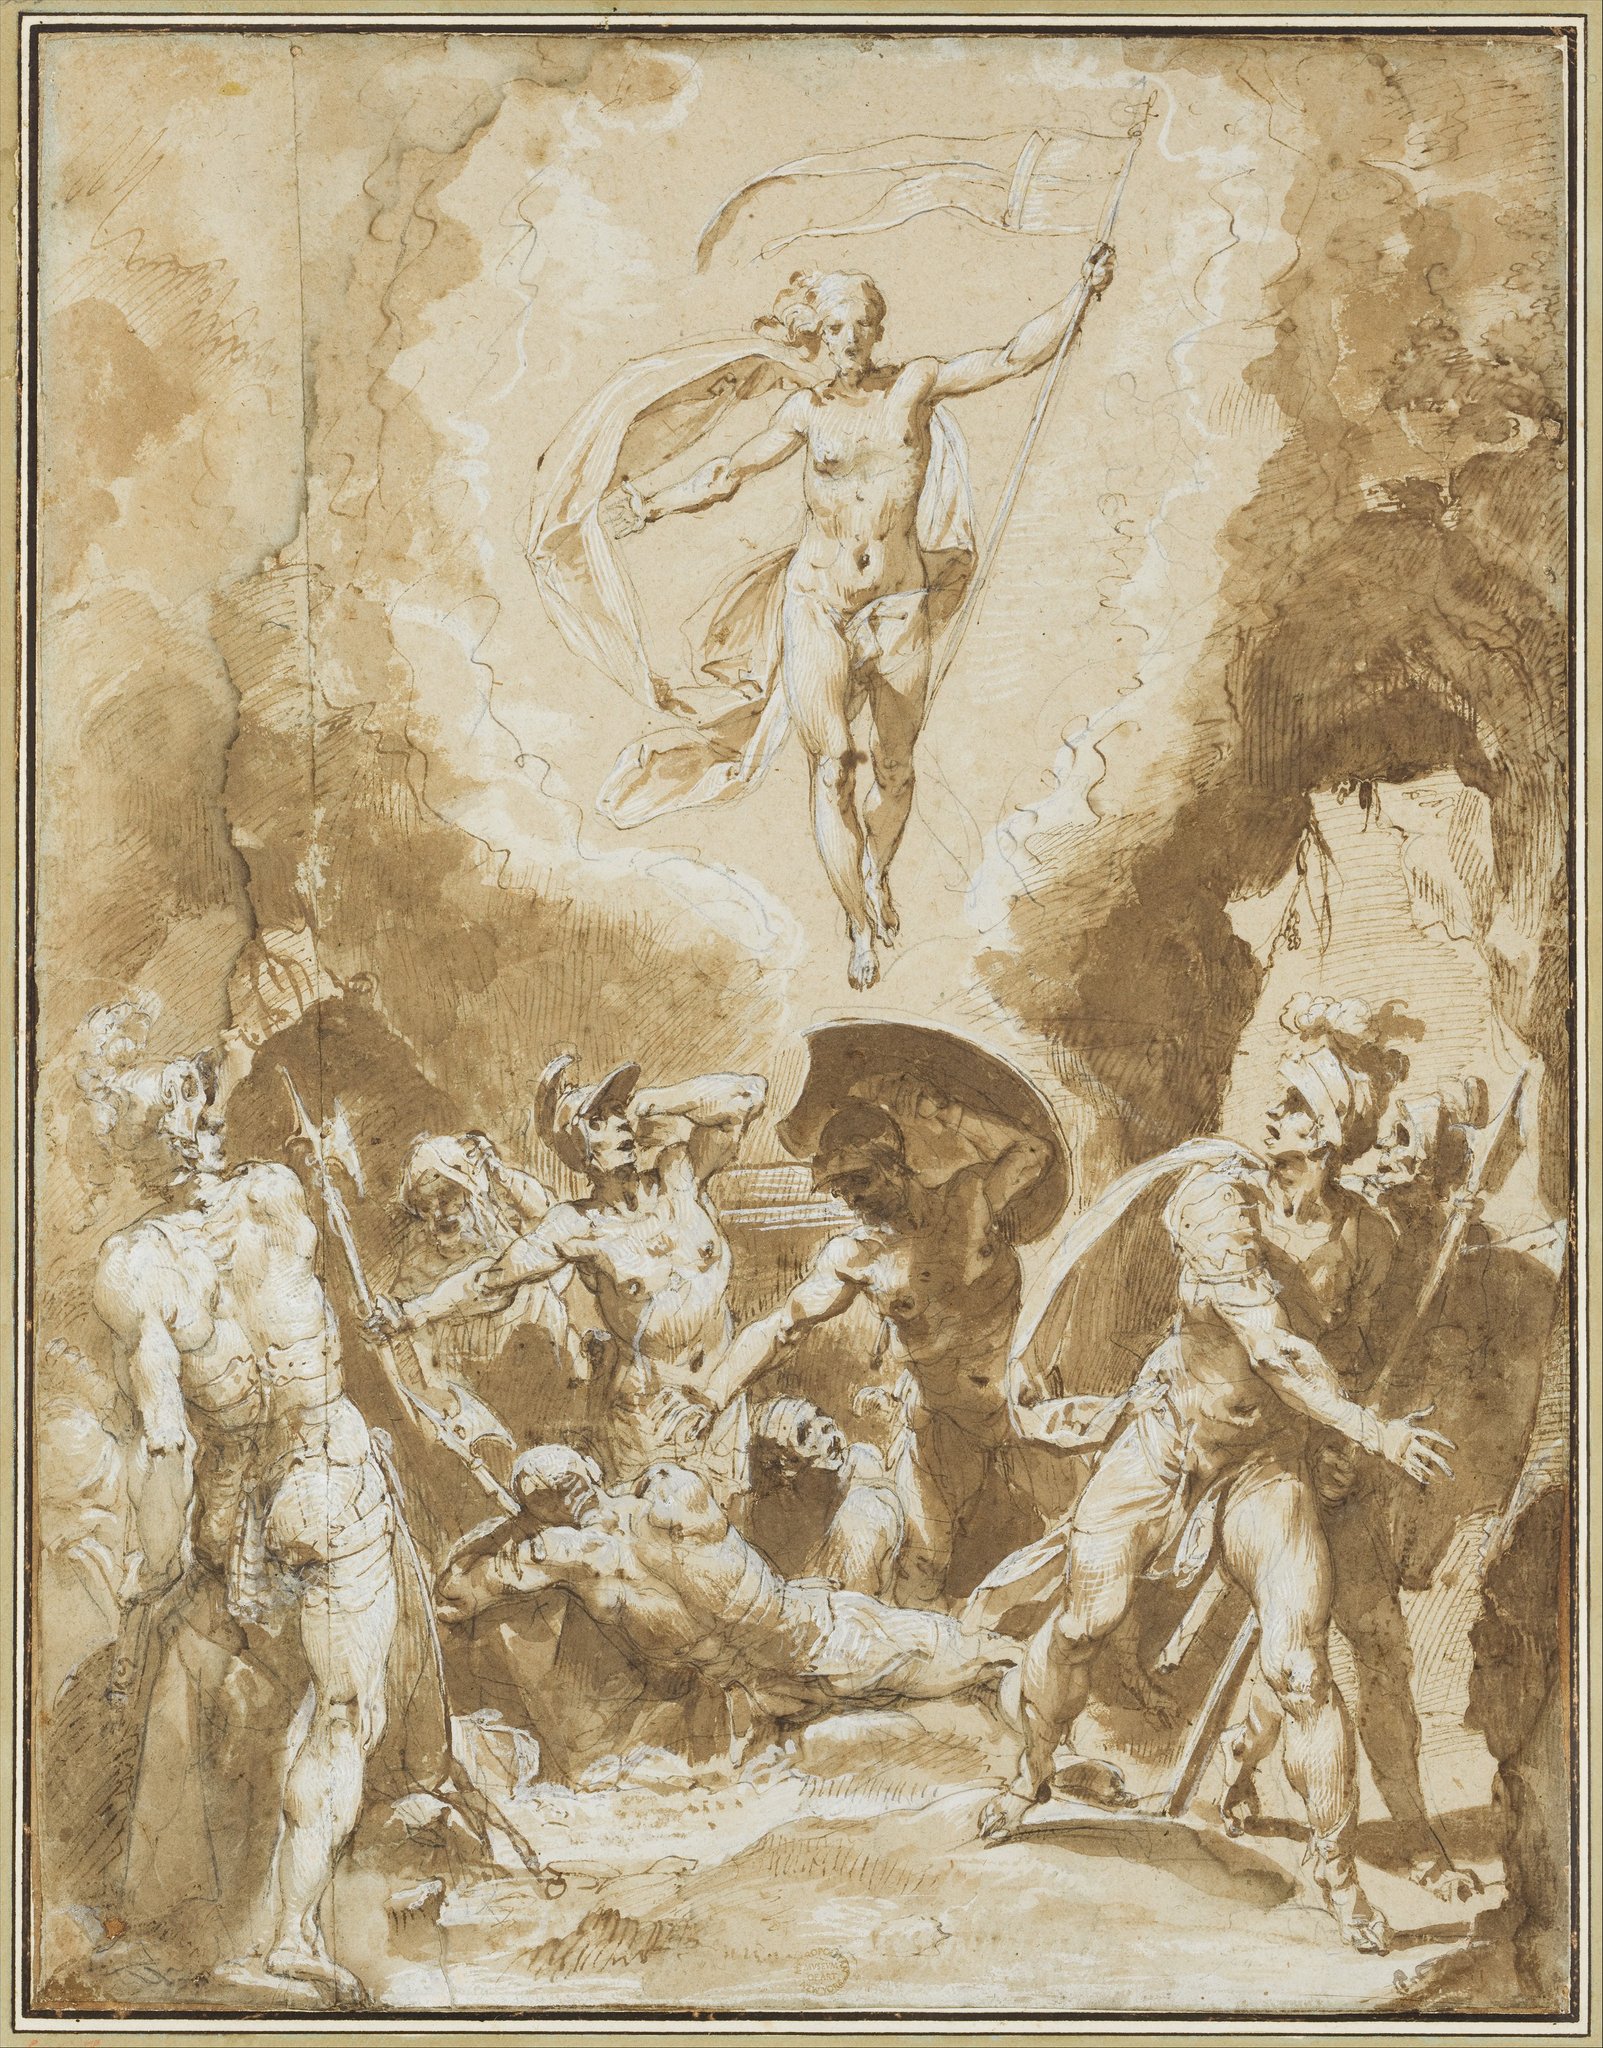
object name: drawing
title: The Resurrection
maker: cavaliere d'arpino (giuseppe cesari)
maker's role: artist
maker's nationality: italian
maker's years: 1568-1640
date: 1600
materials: chalk, ink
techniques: brush, highlighting, pen, wash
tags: men,christ,resurrection